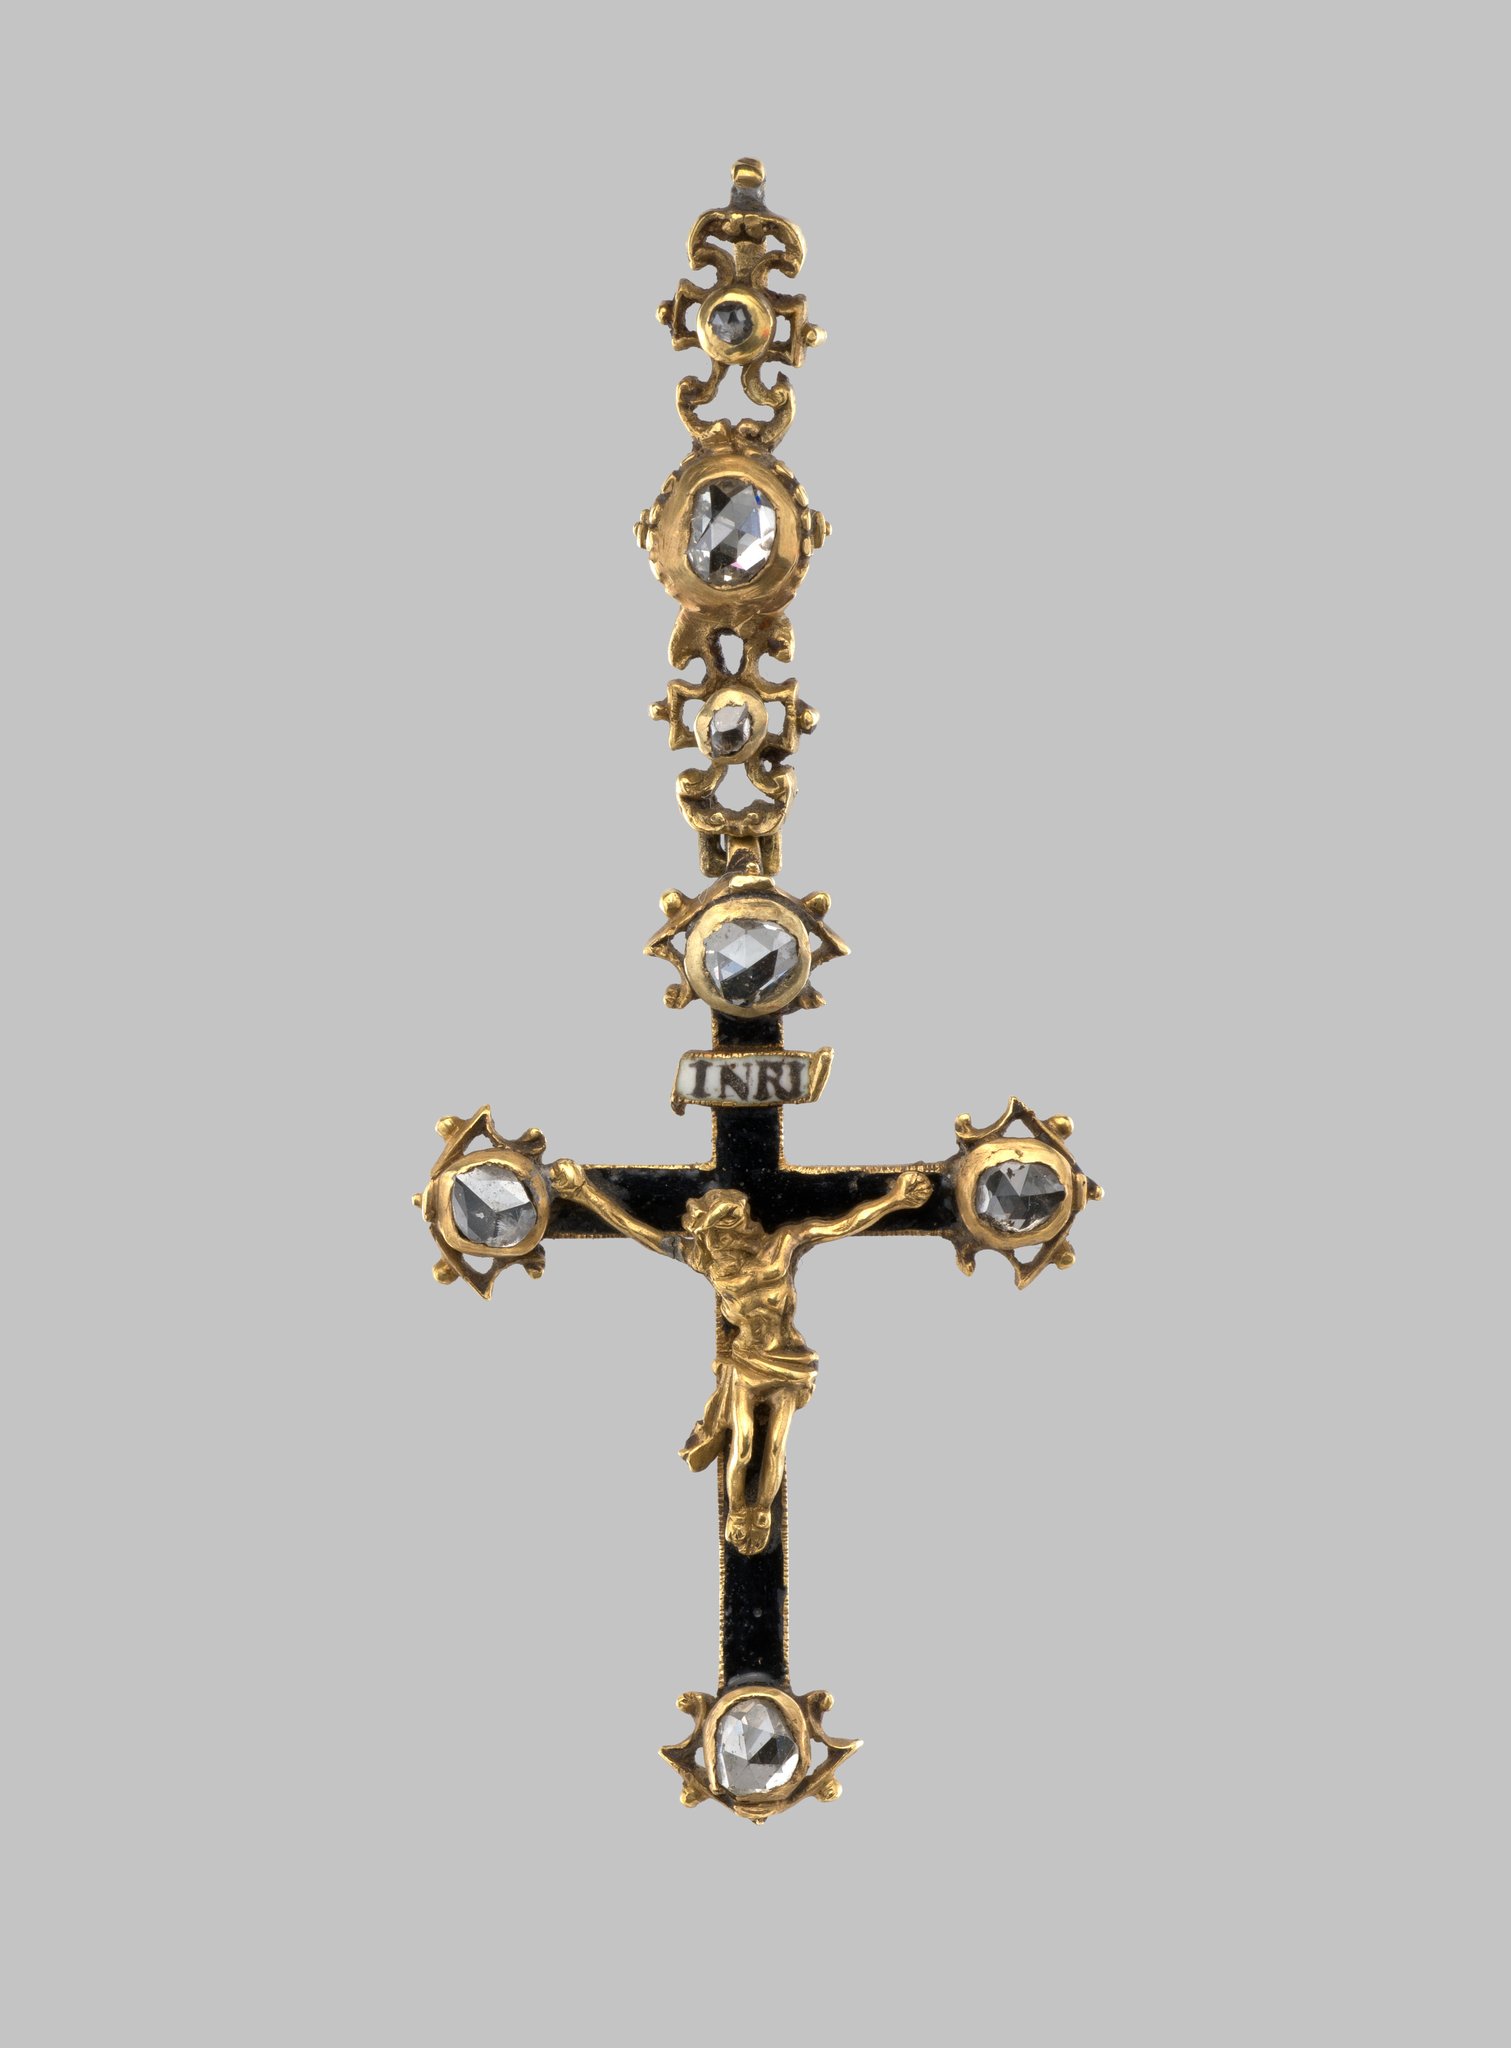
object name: pendant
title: Crucifix pendant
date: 1601-1700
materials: diamond, enamel, gold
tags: christ,cross,crucifixion